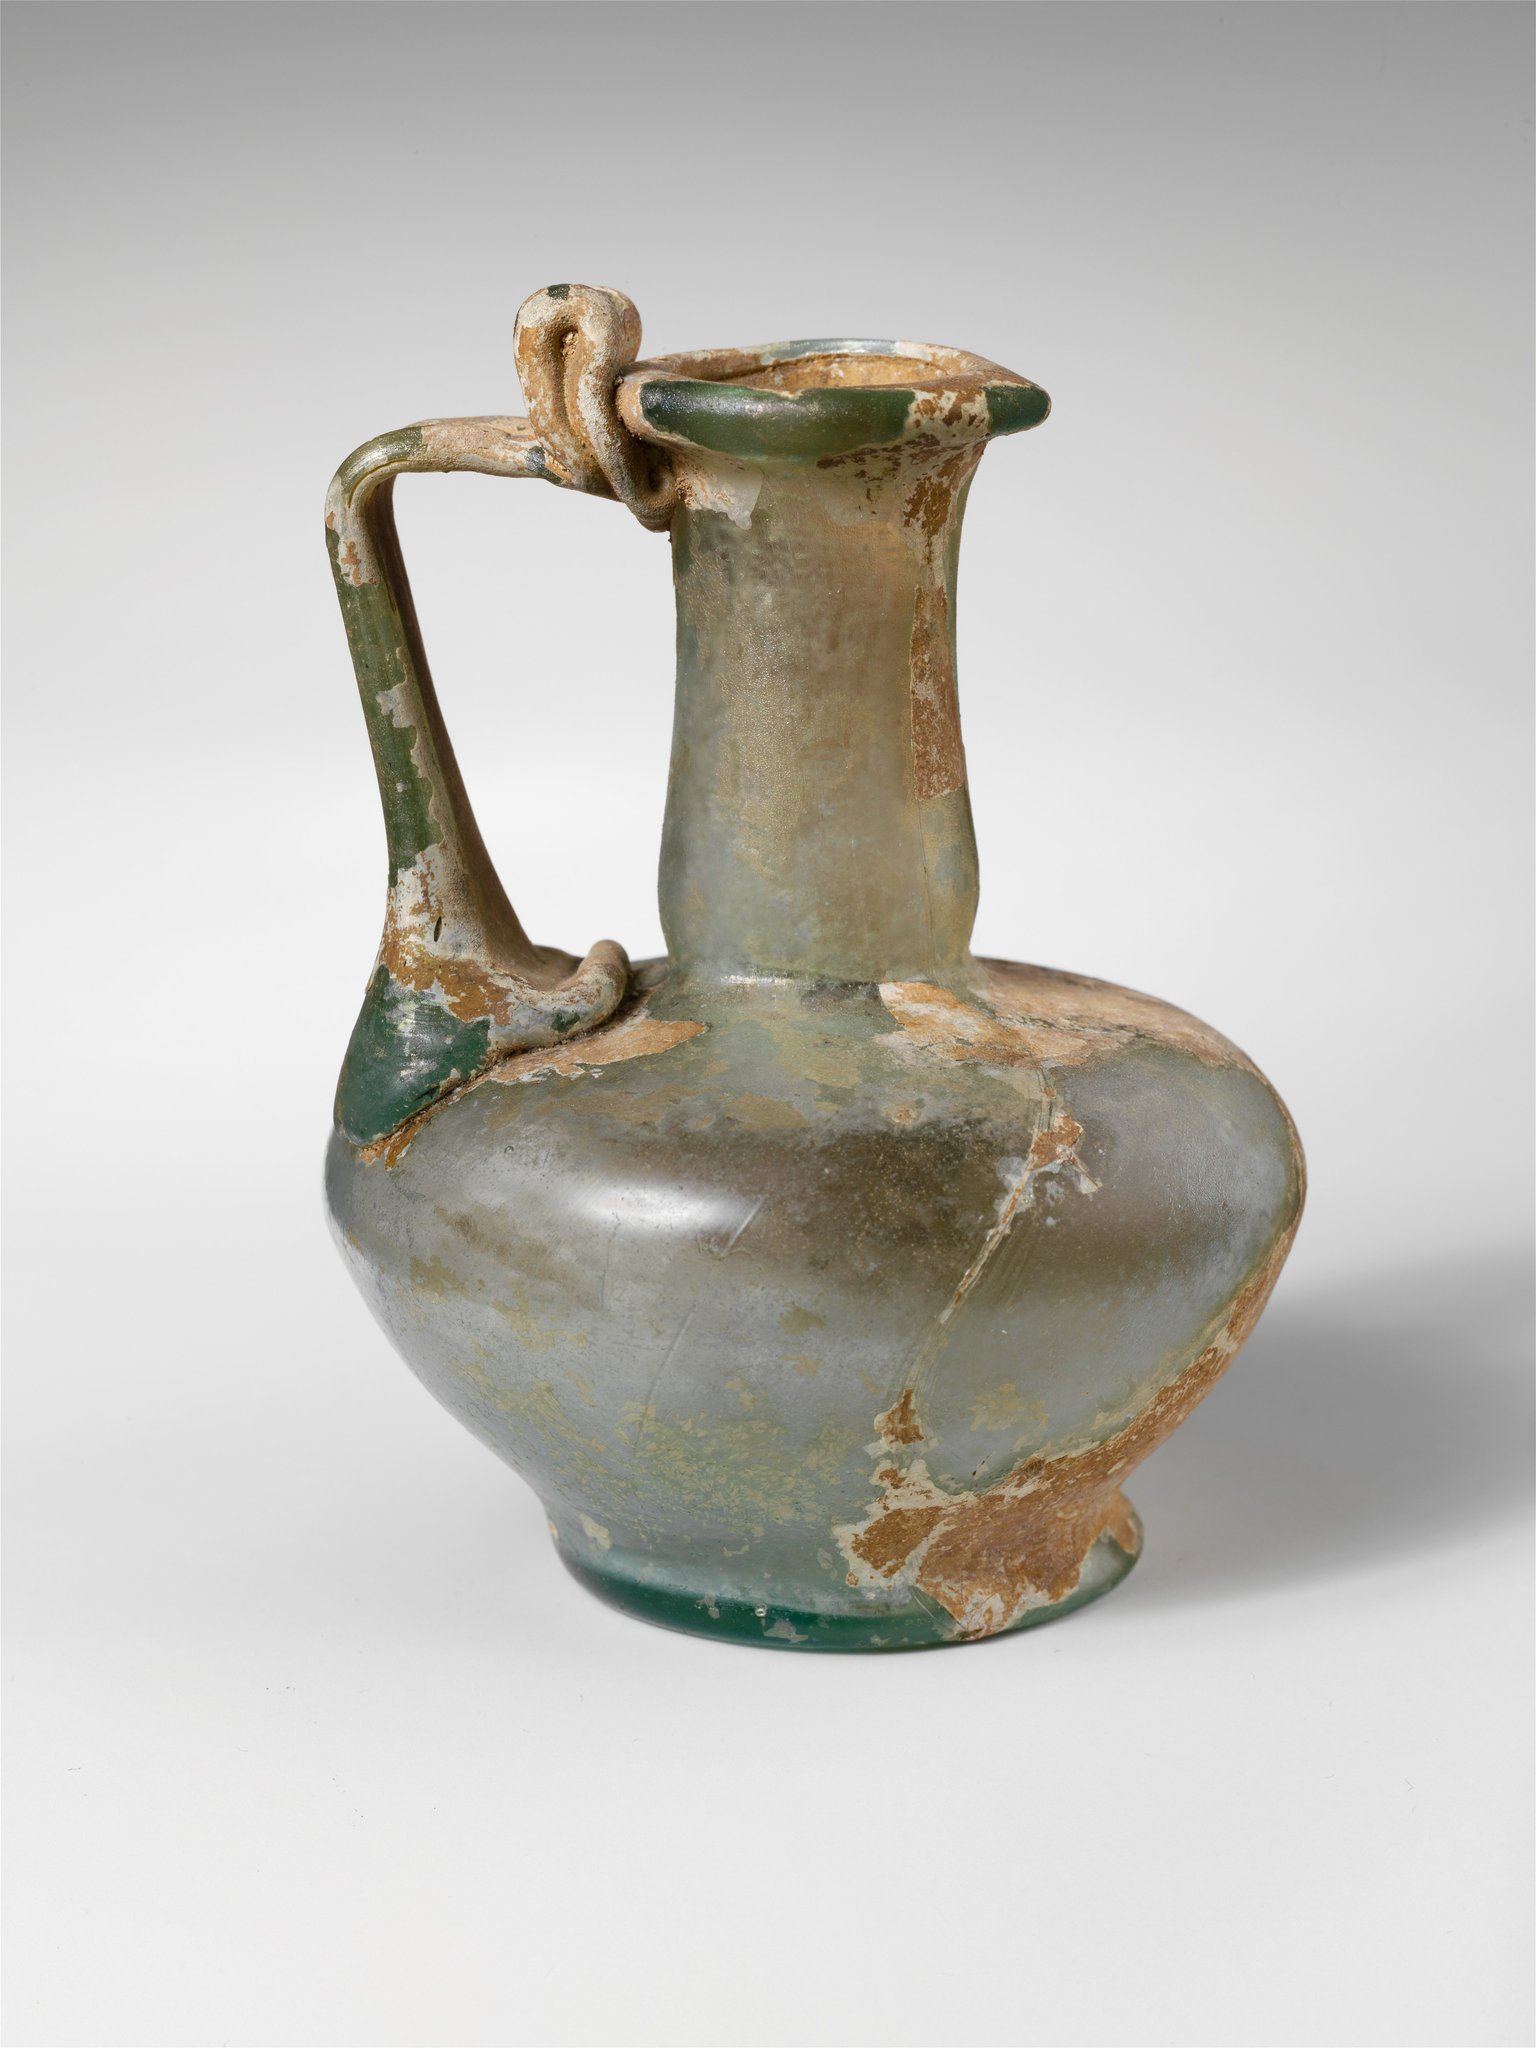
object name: jug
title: Glass jug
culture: roman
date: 1-200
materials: glass